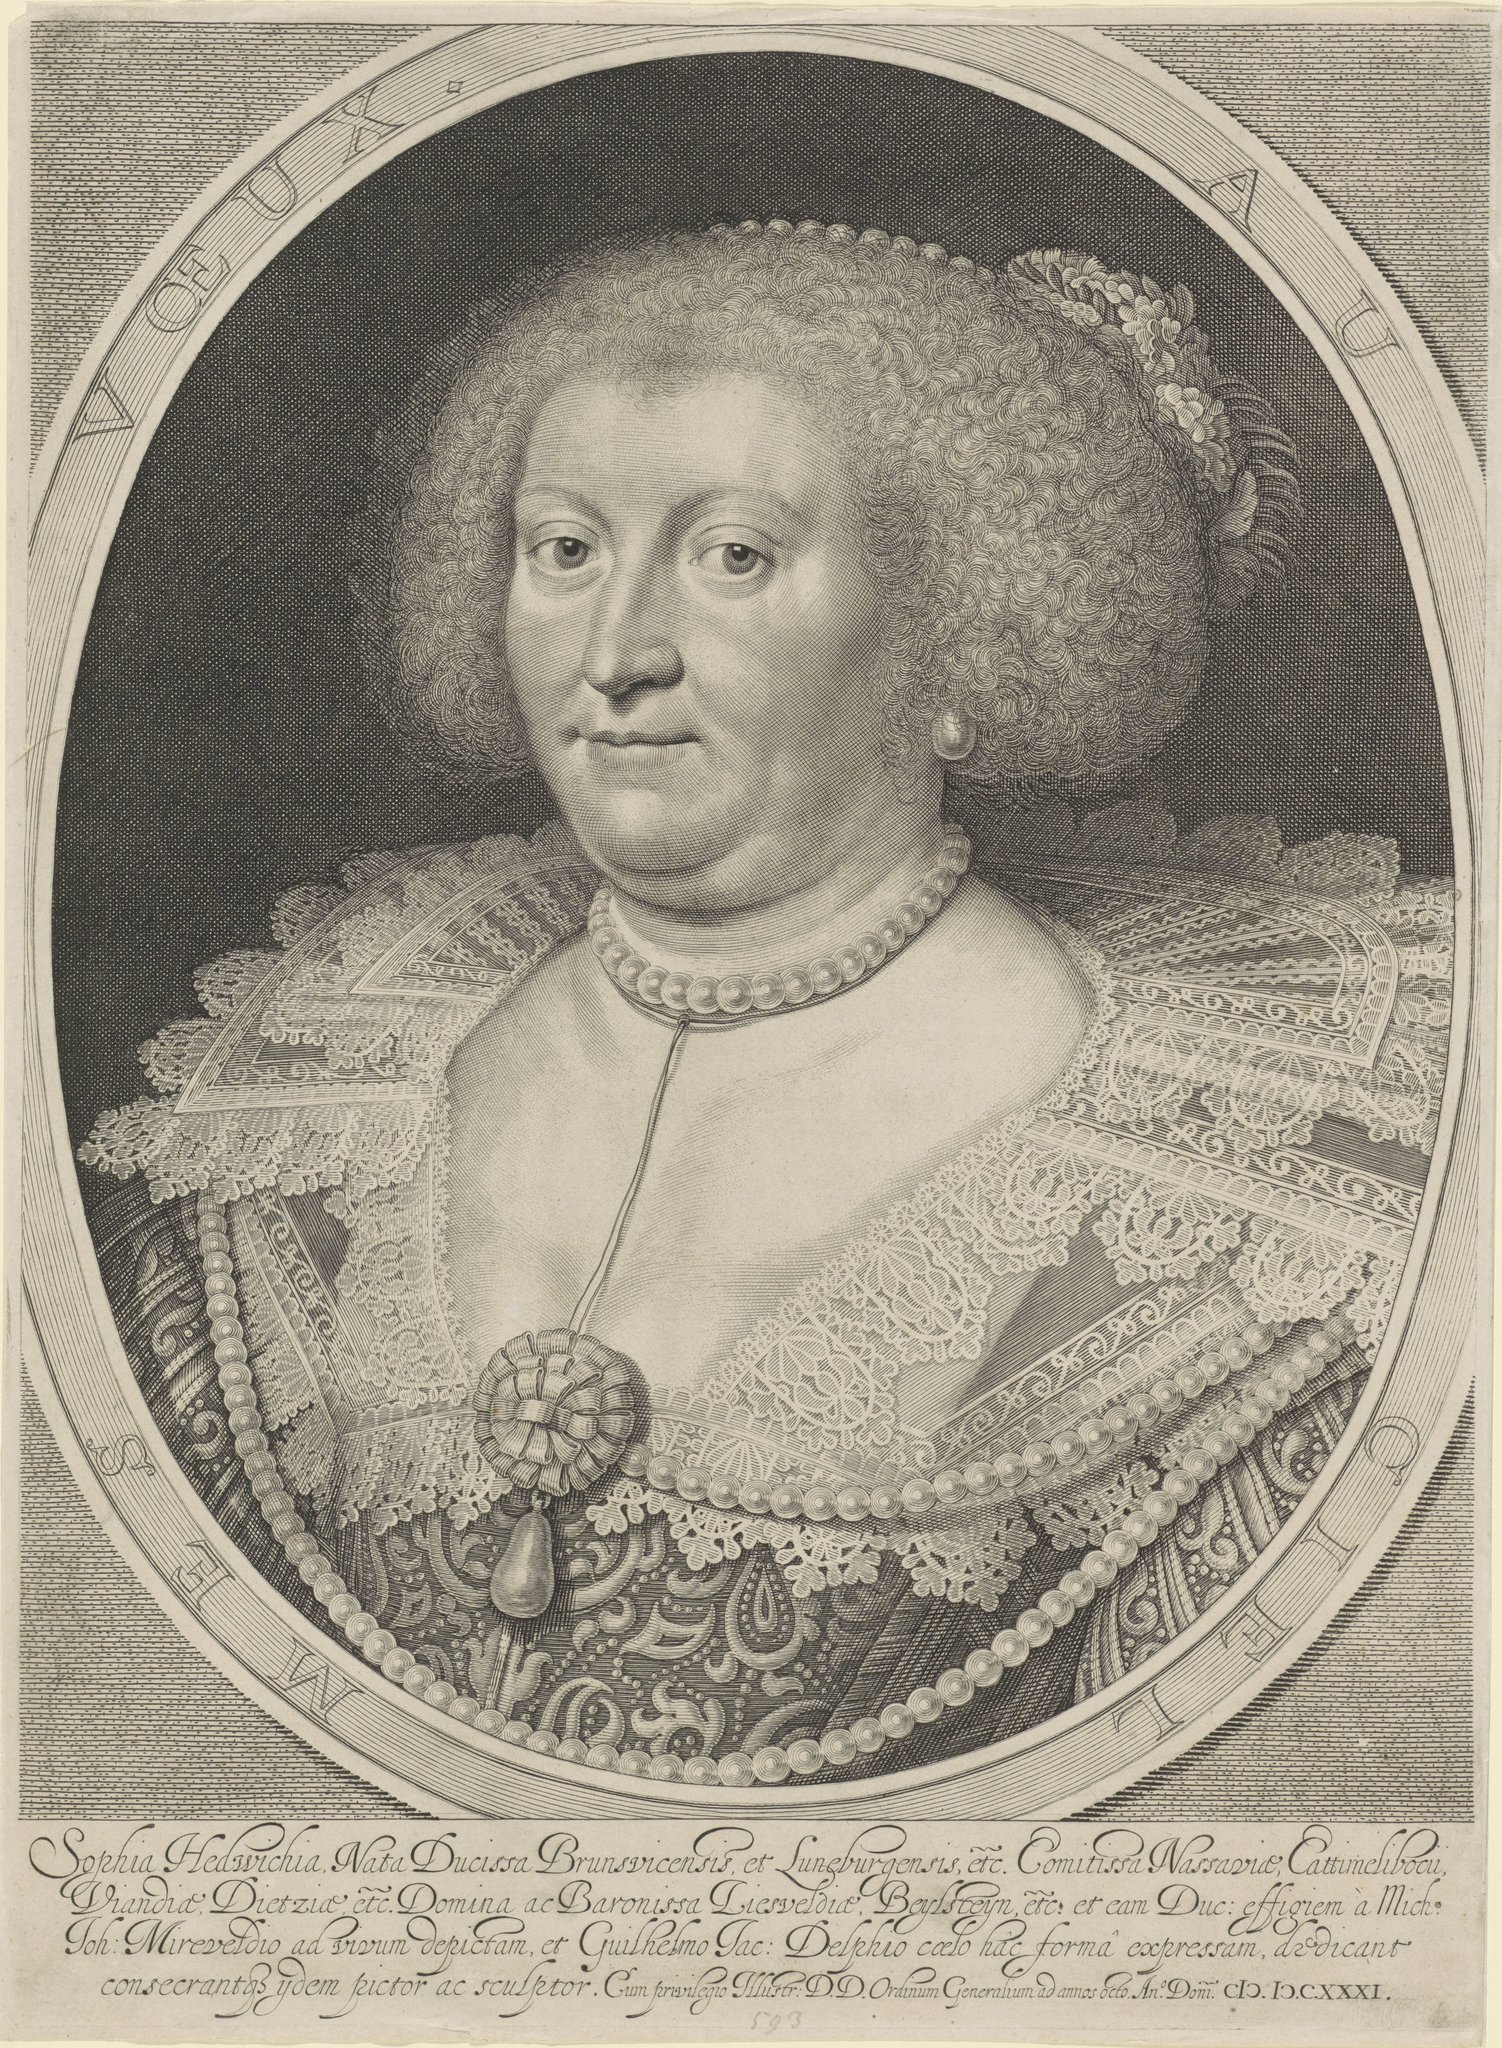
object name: print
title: Portret van Sophia Hedwig van Brunswijk-Wolfenbüttel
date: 1631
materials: paper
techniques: engraving, etching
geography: delft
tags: sophia hedwig van brunswijk-wolfenbüttel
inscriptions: date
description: Portret van Sophia Hedwig van Brunswijk-Wolfenbüttel in een ovaal met randschrift. In de ondermarge vier regels Latijnse tekst.